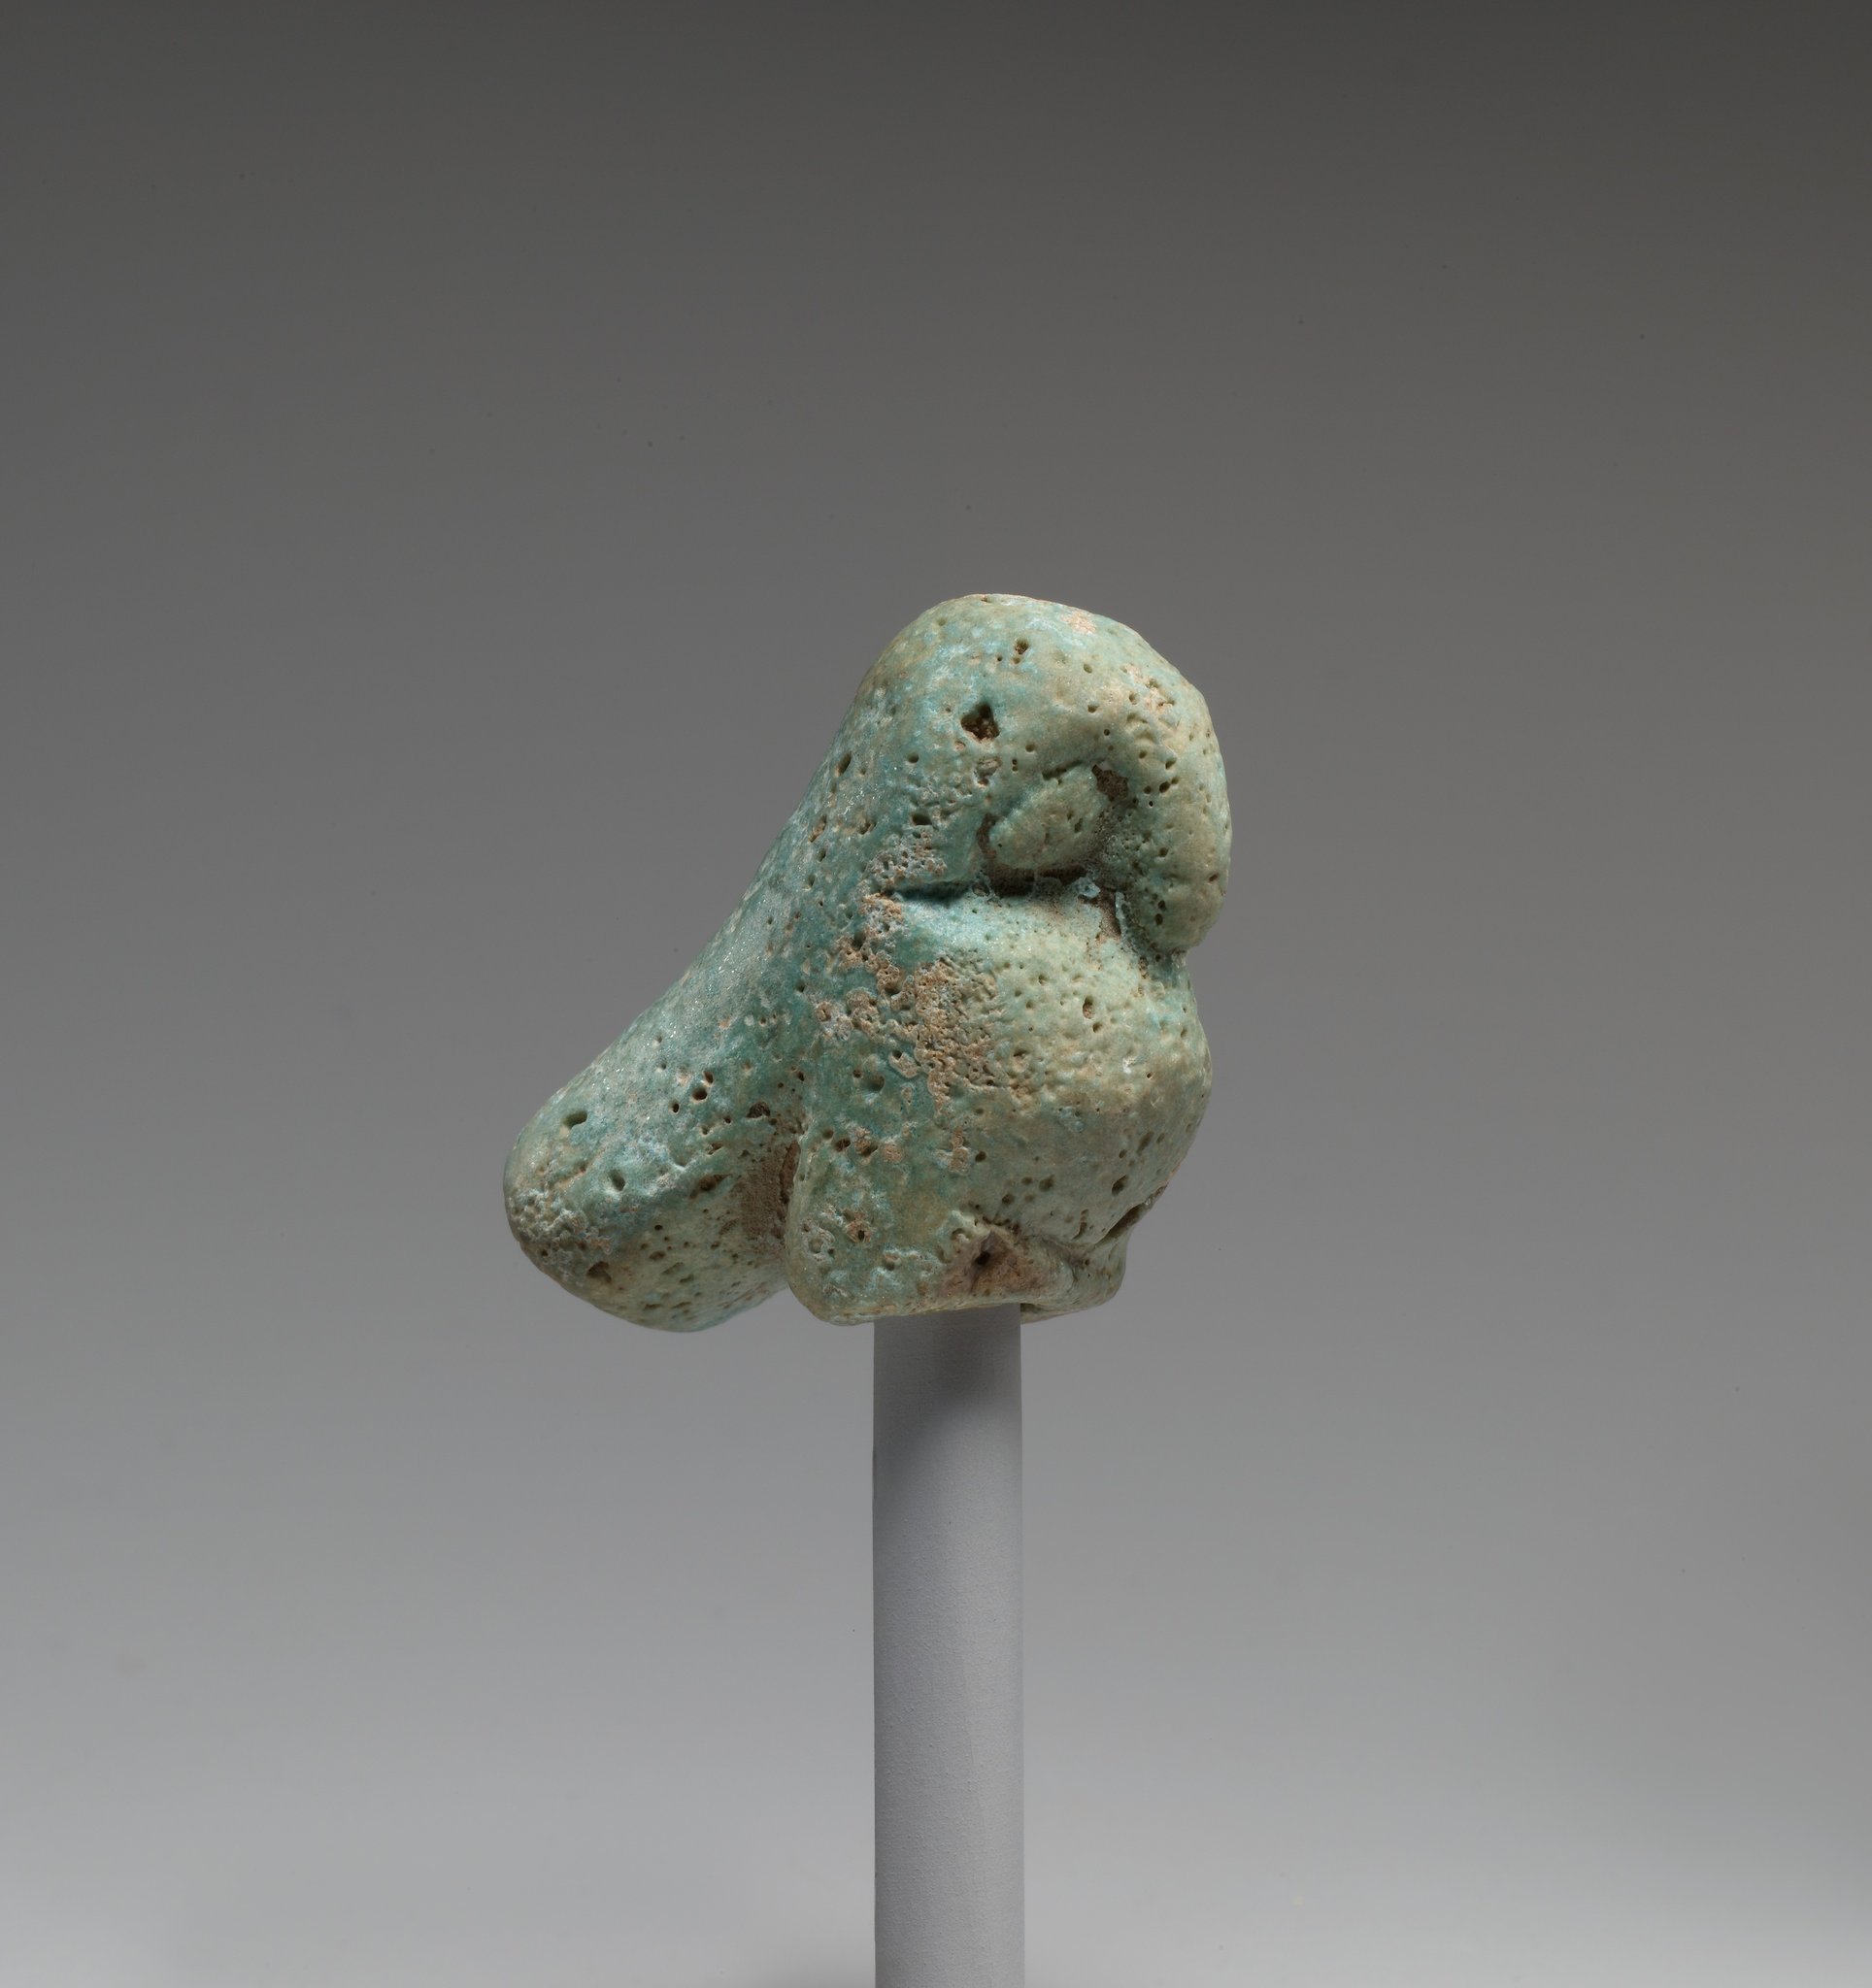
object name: figurine, falcon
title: Figurine of a crouching falcon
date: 3100-2650 BCE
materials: faience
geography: egypt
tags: falcons